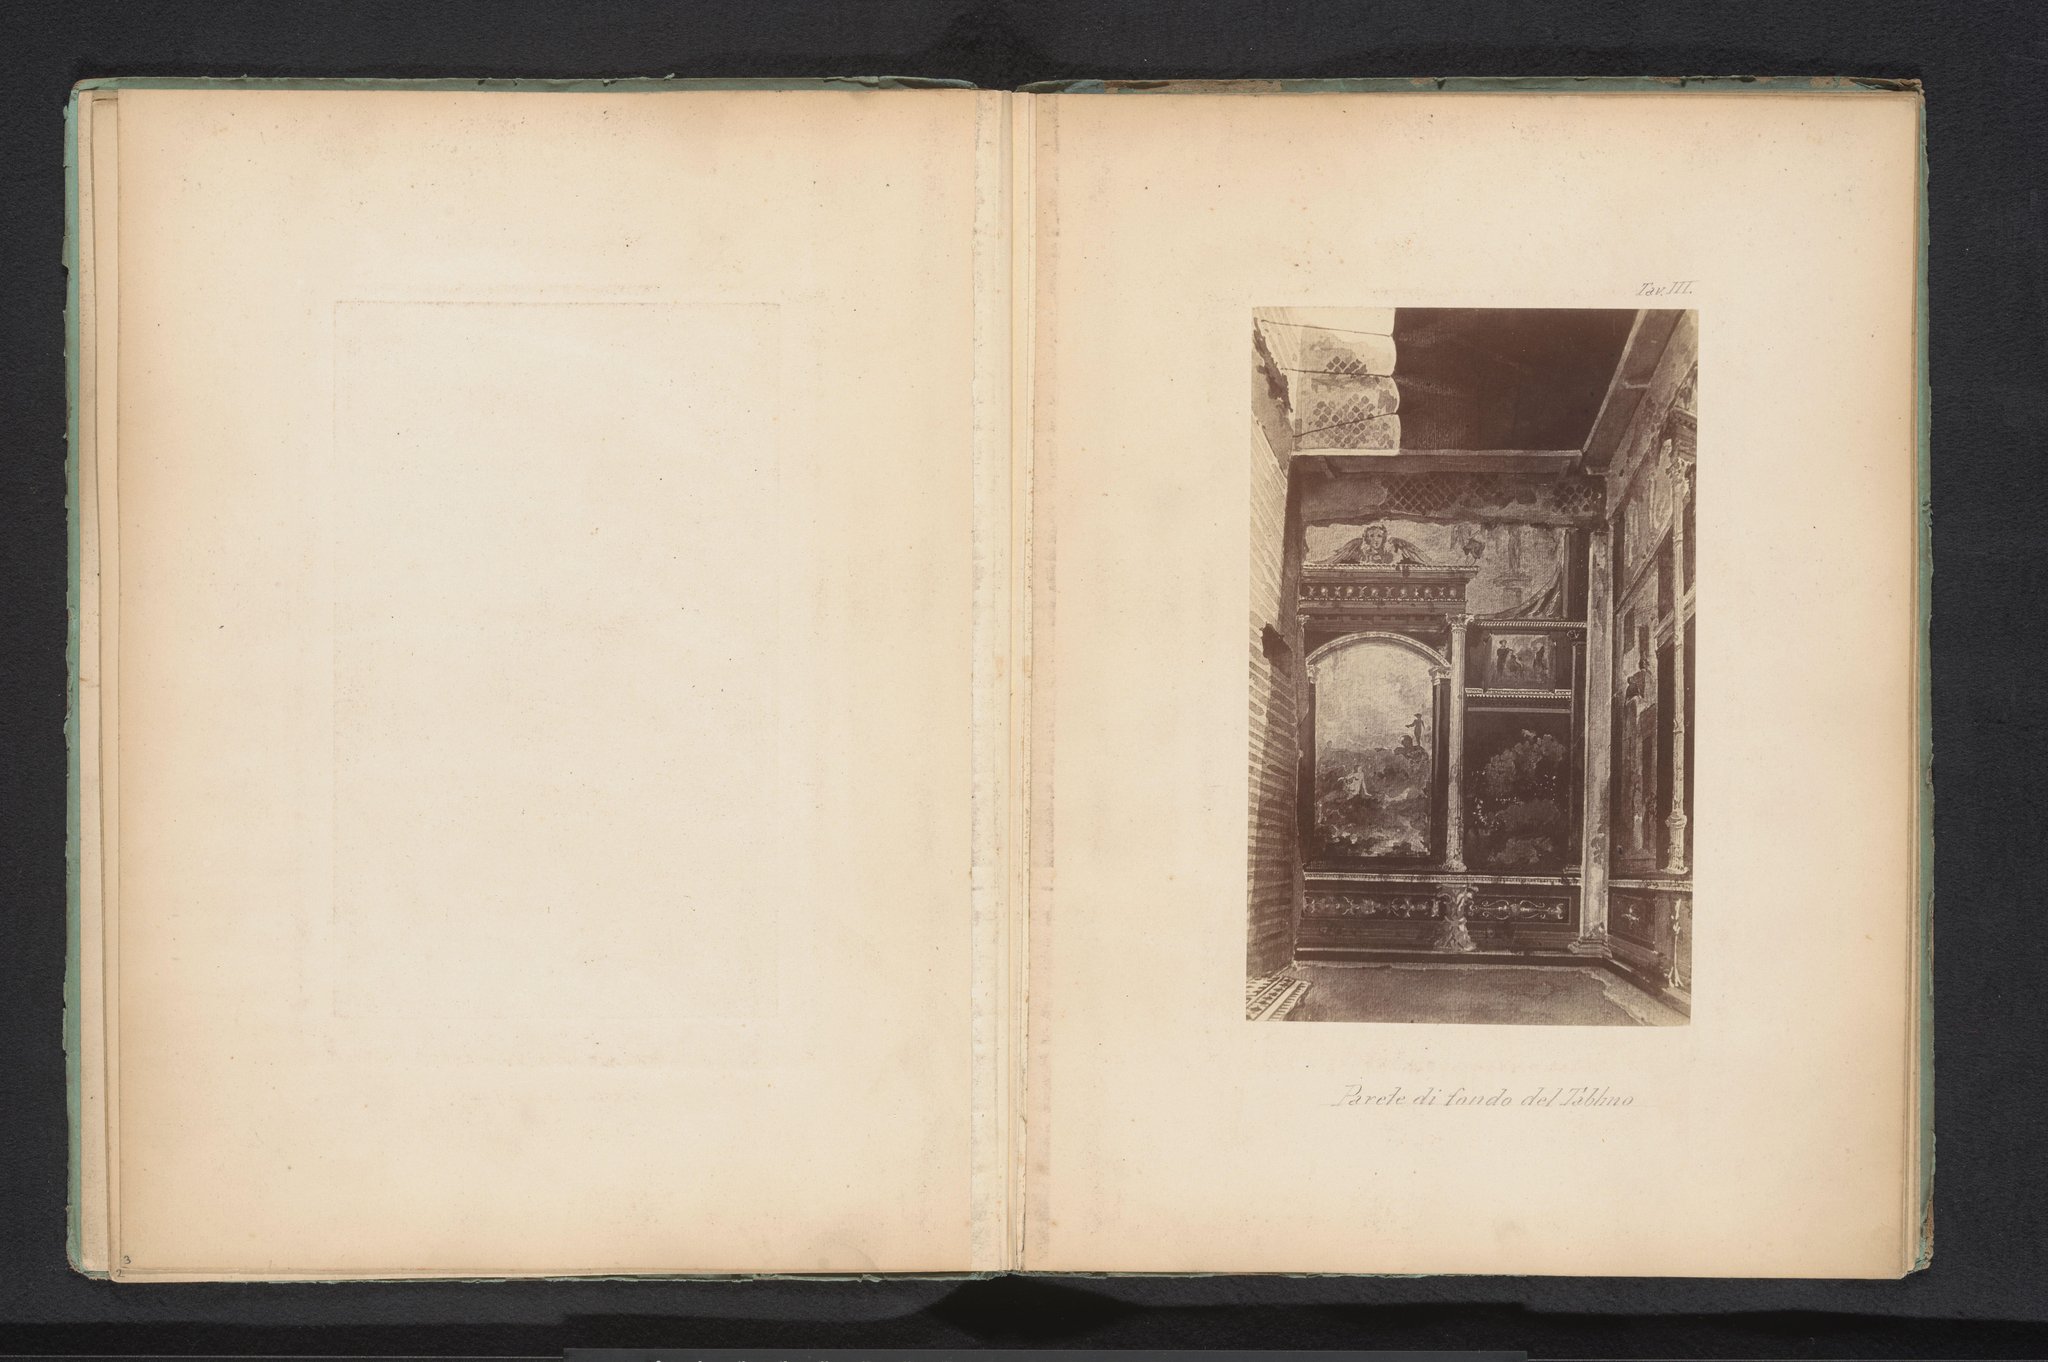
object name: reproduction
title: Parete di fondo del Tablino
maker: Anonymous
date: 1859-1869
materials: photographic support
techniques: albumen print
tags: vestibule, hall, ruin of a dwelling, house, castle, etc., rome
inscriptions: number: ‘Tav. III.’